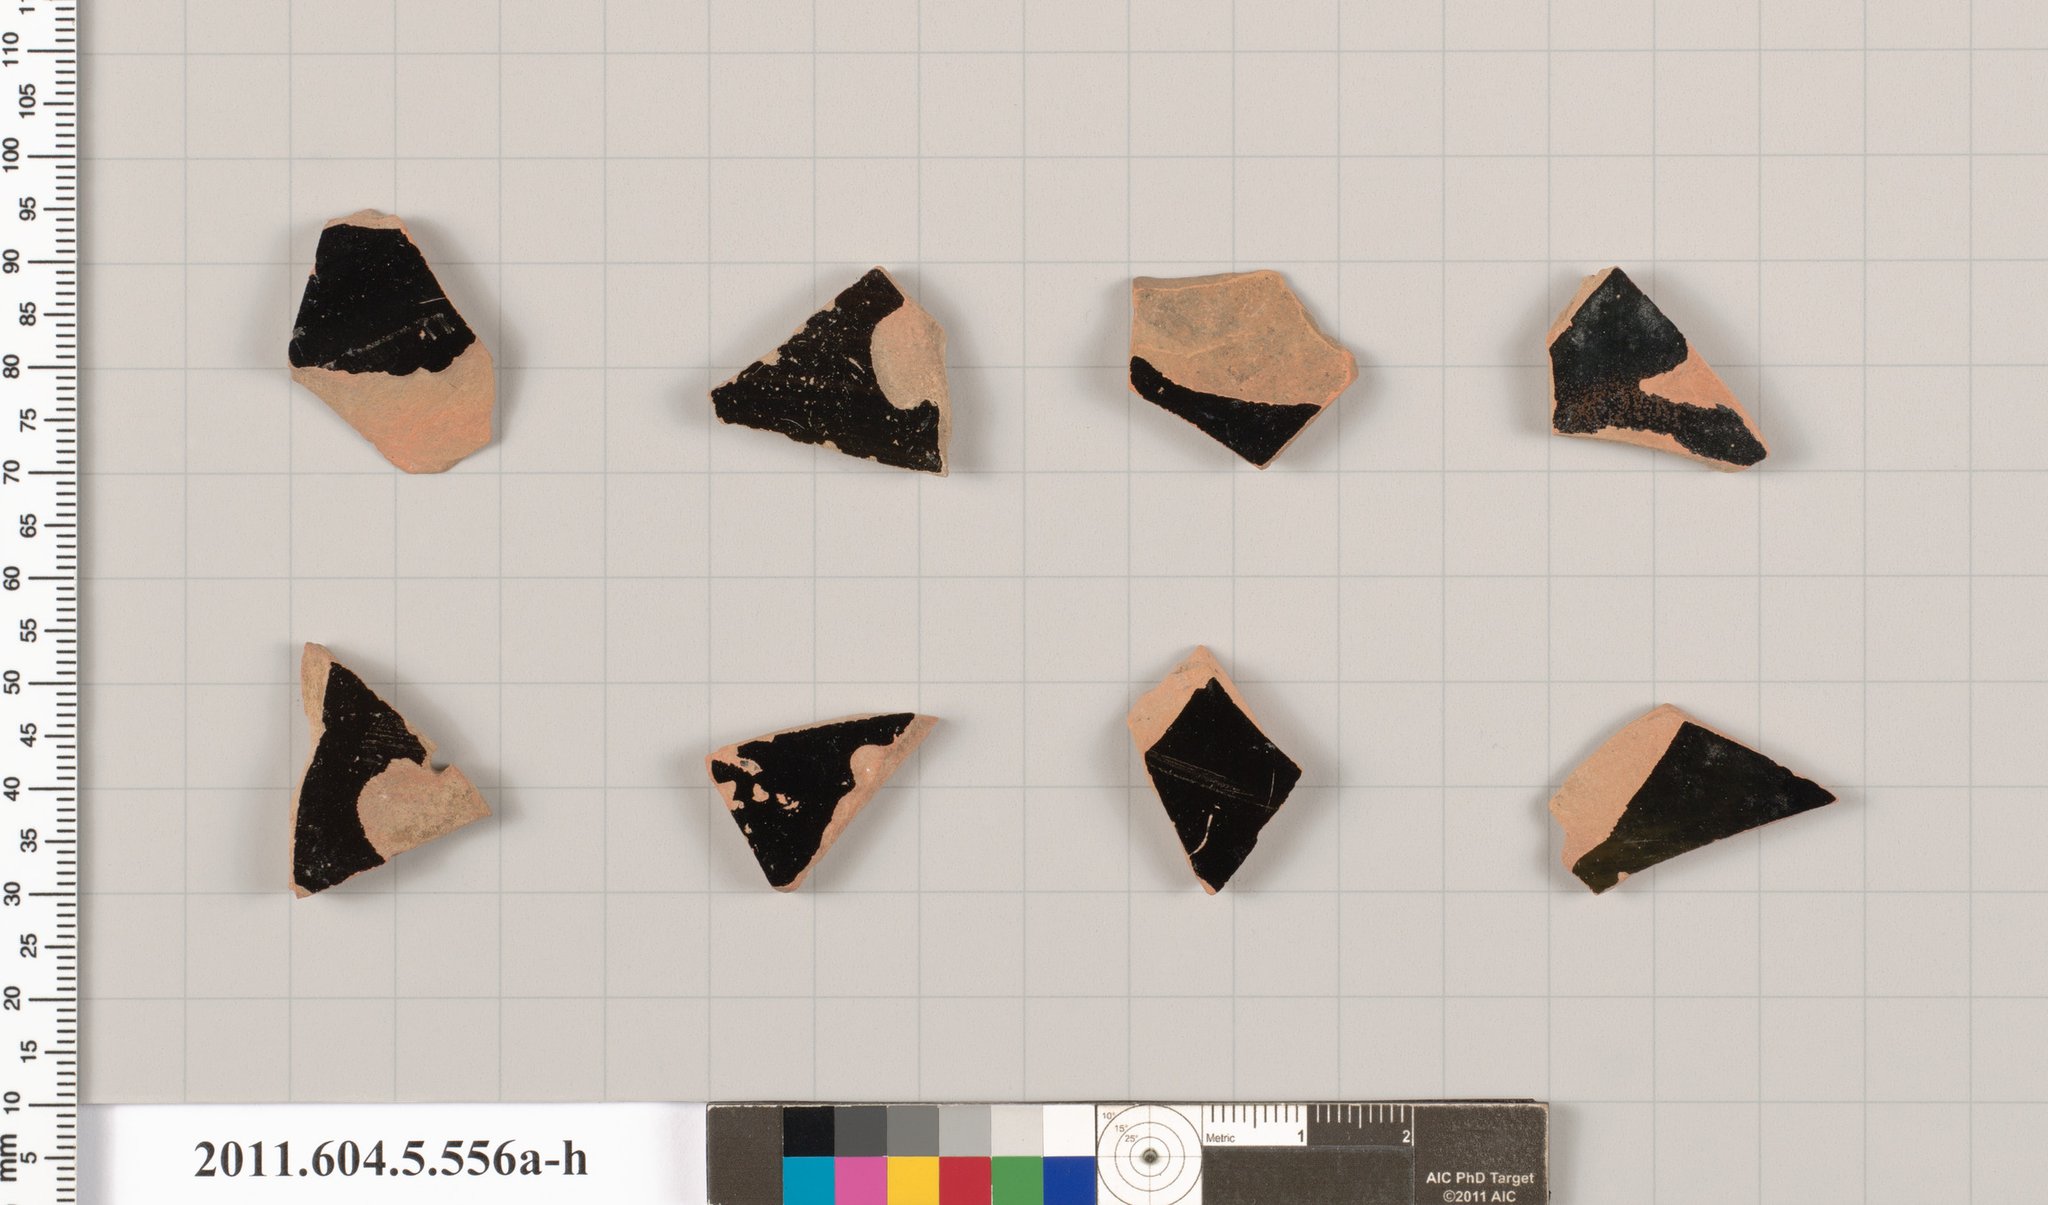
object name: kylix fragment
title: Terracotta fragments of kylikes (drinking cups)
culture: greek, attic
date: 600-401 BCE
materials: terracotta